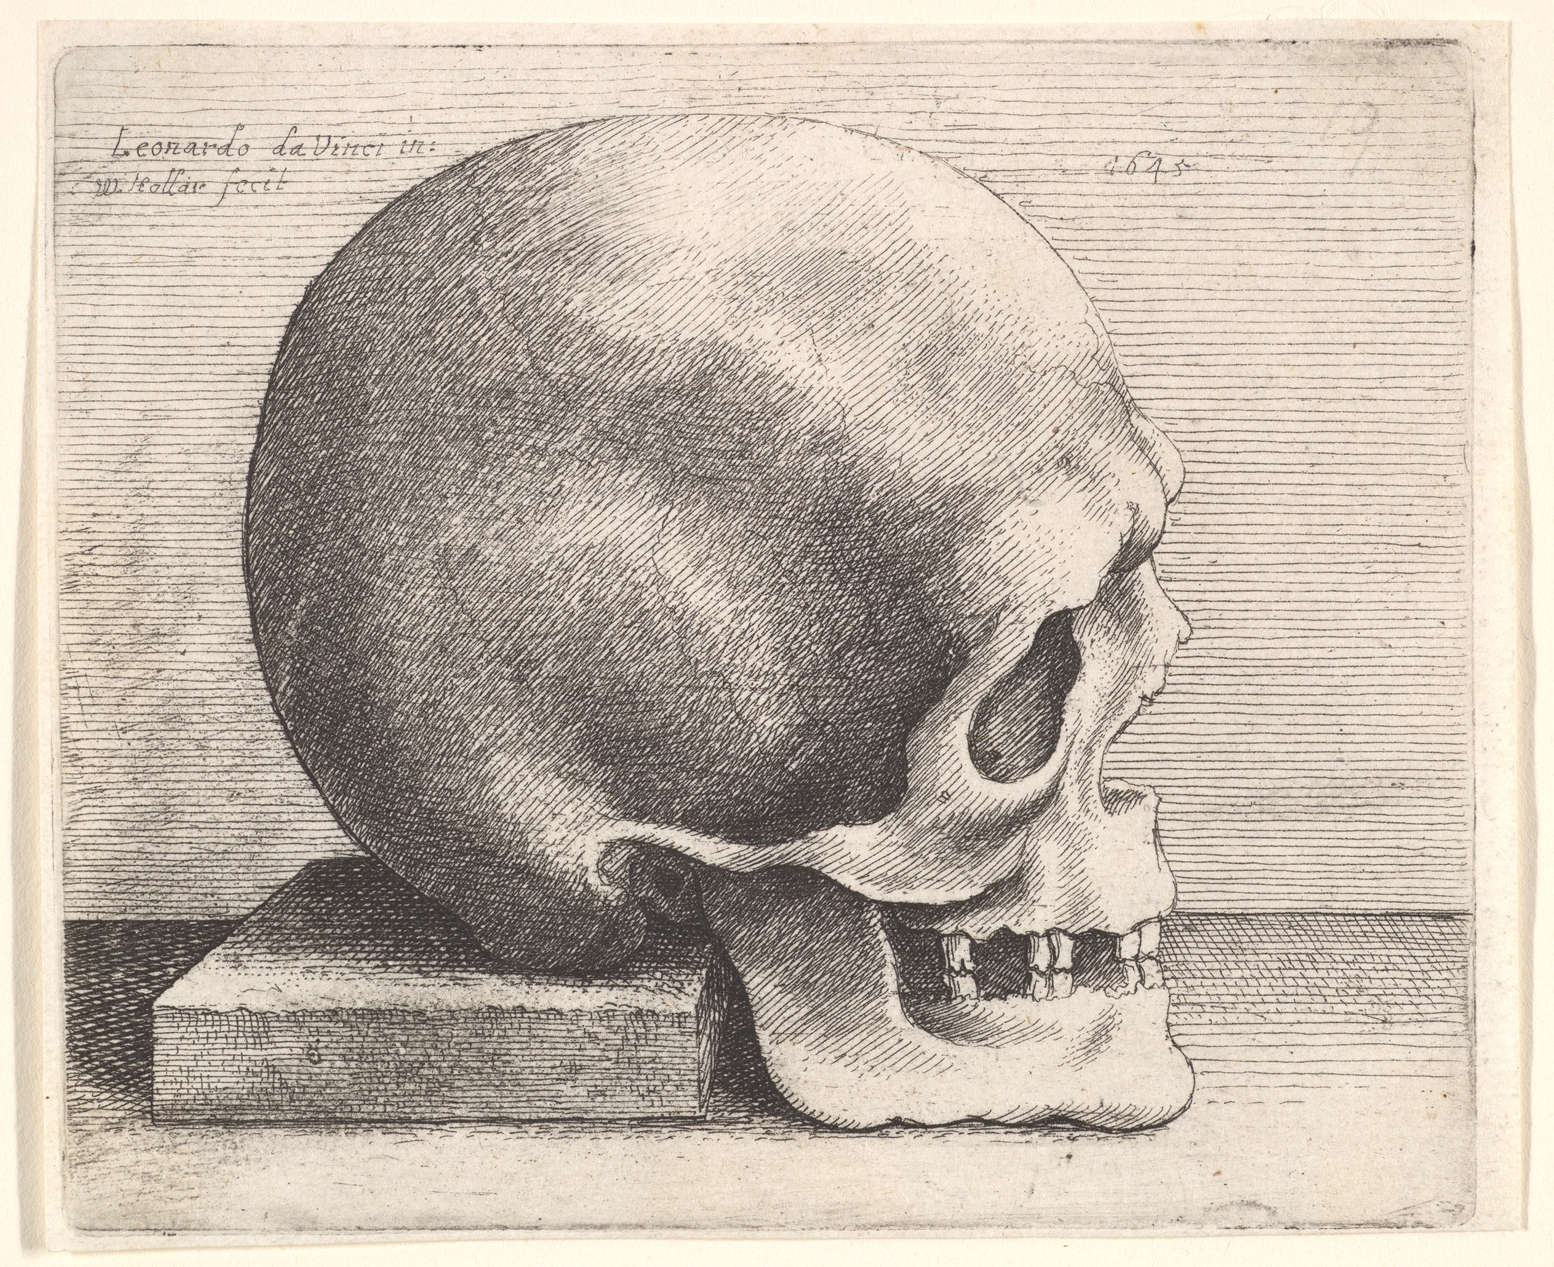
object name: print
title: Skull in profile to right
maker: wenceslaus hollar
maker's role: artist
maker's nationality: bohemian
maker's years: 1607-1677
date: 1645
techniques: etching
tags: skulls